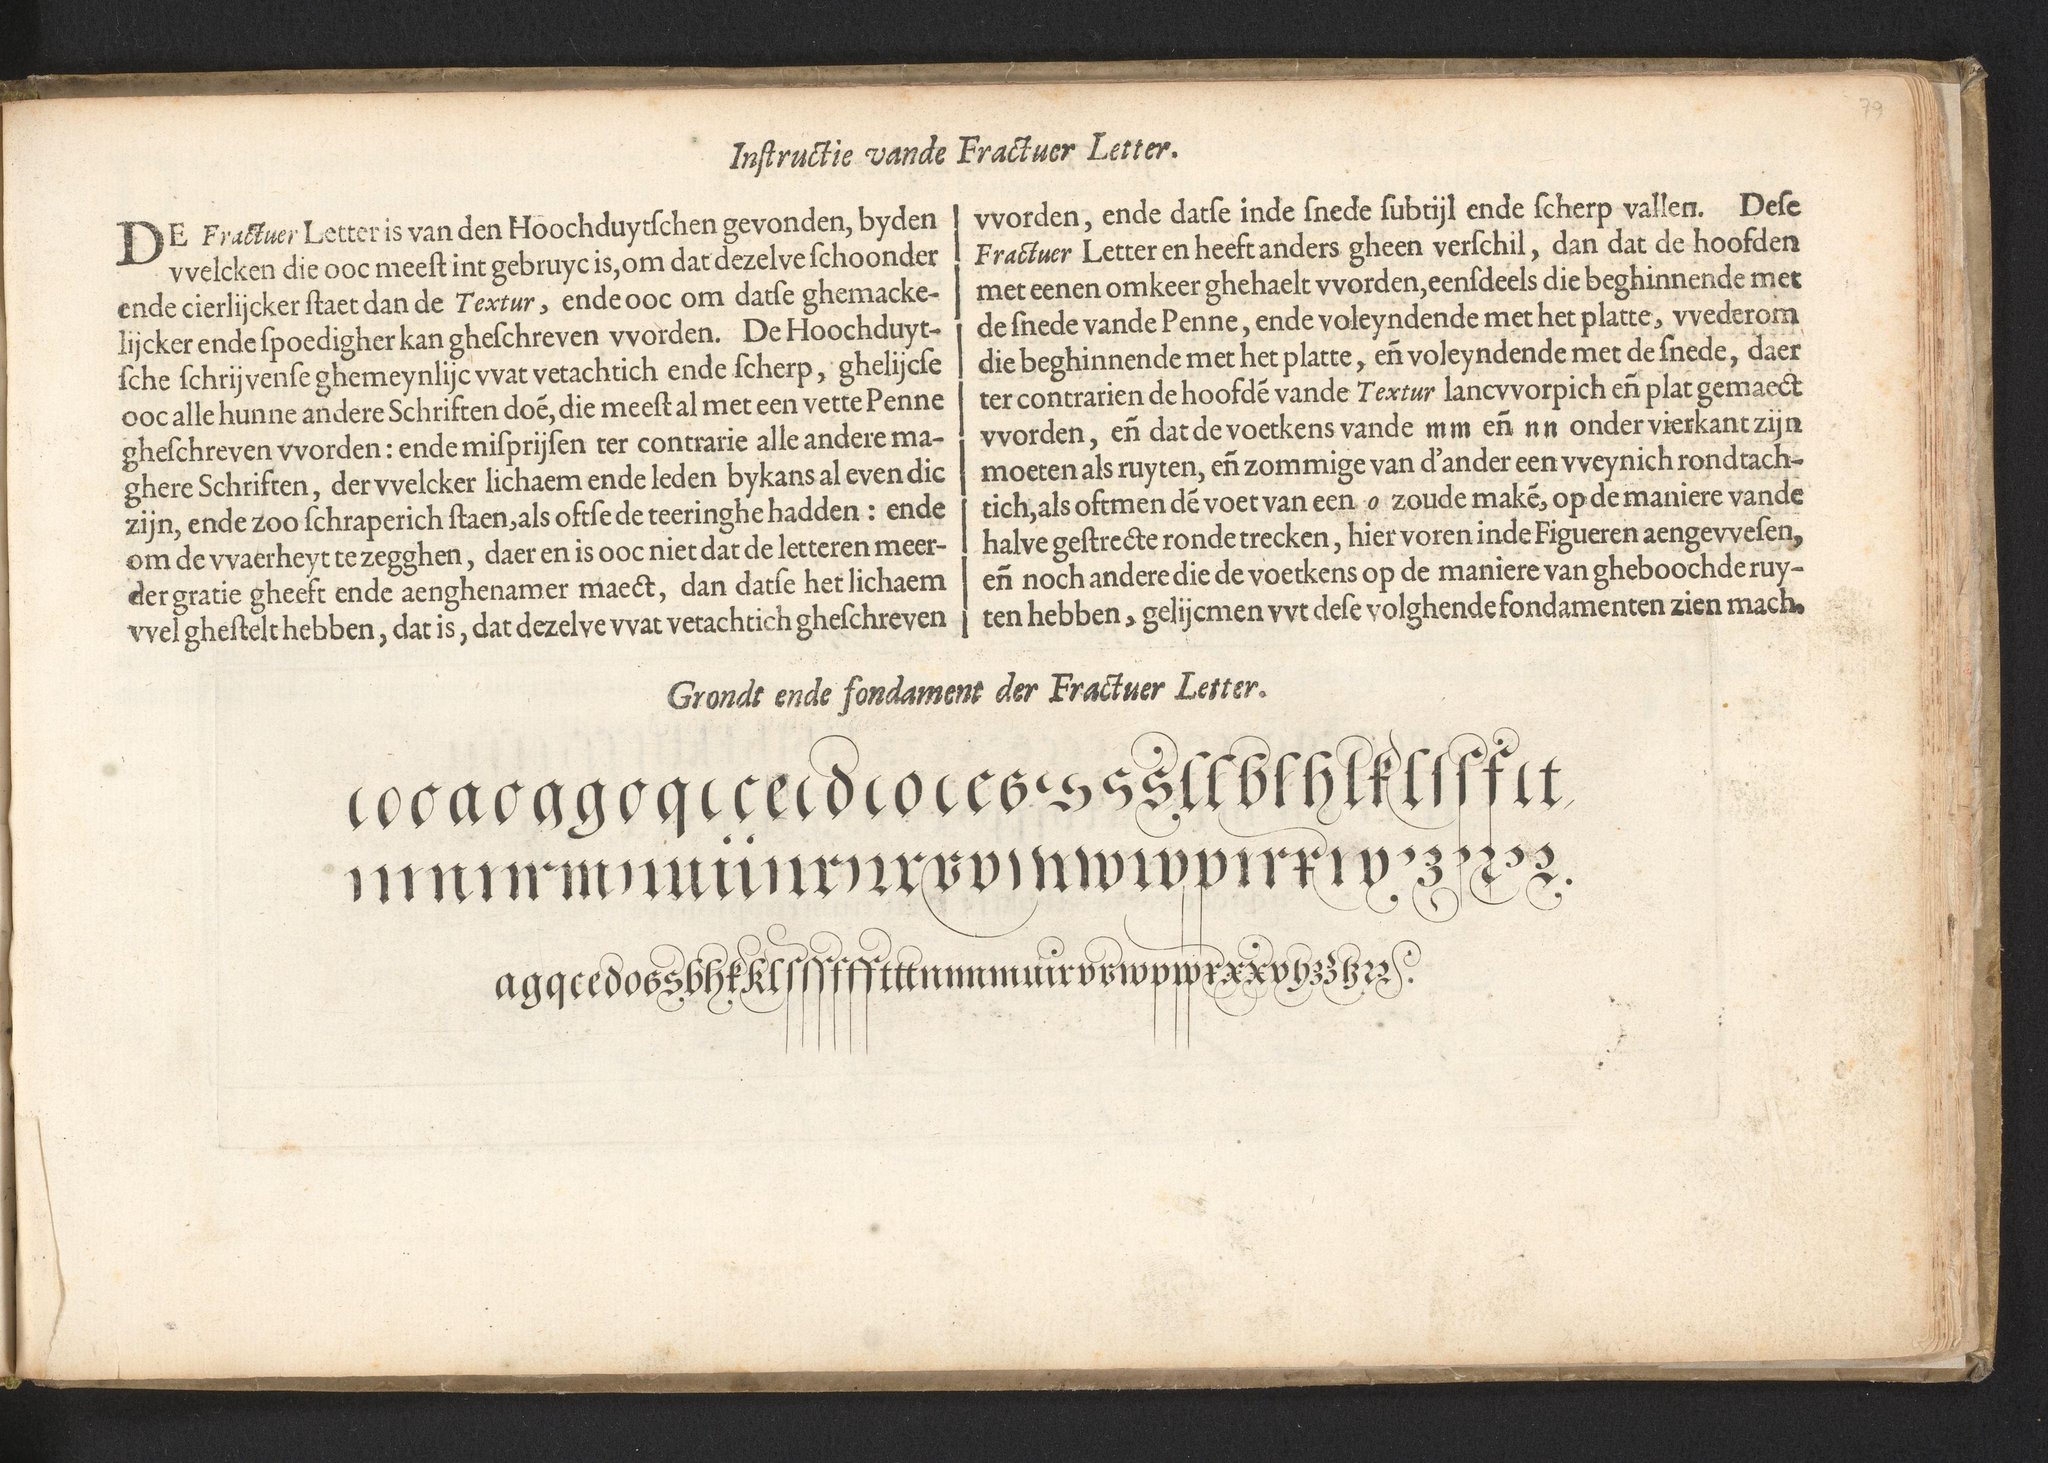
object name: text sheet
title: Fondement-Boeck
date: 1605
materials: paper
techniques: engraving, letterpress printing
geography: haarlem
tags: calligraphy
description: Folio E2r met een beschrijving en een schrijfvoorbeeld van de Fraktuer Letter. Het blad maakt deel uit van een album.